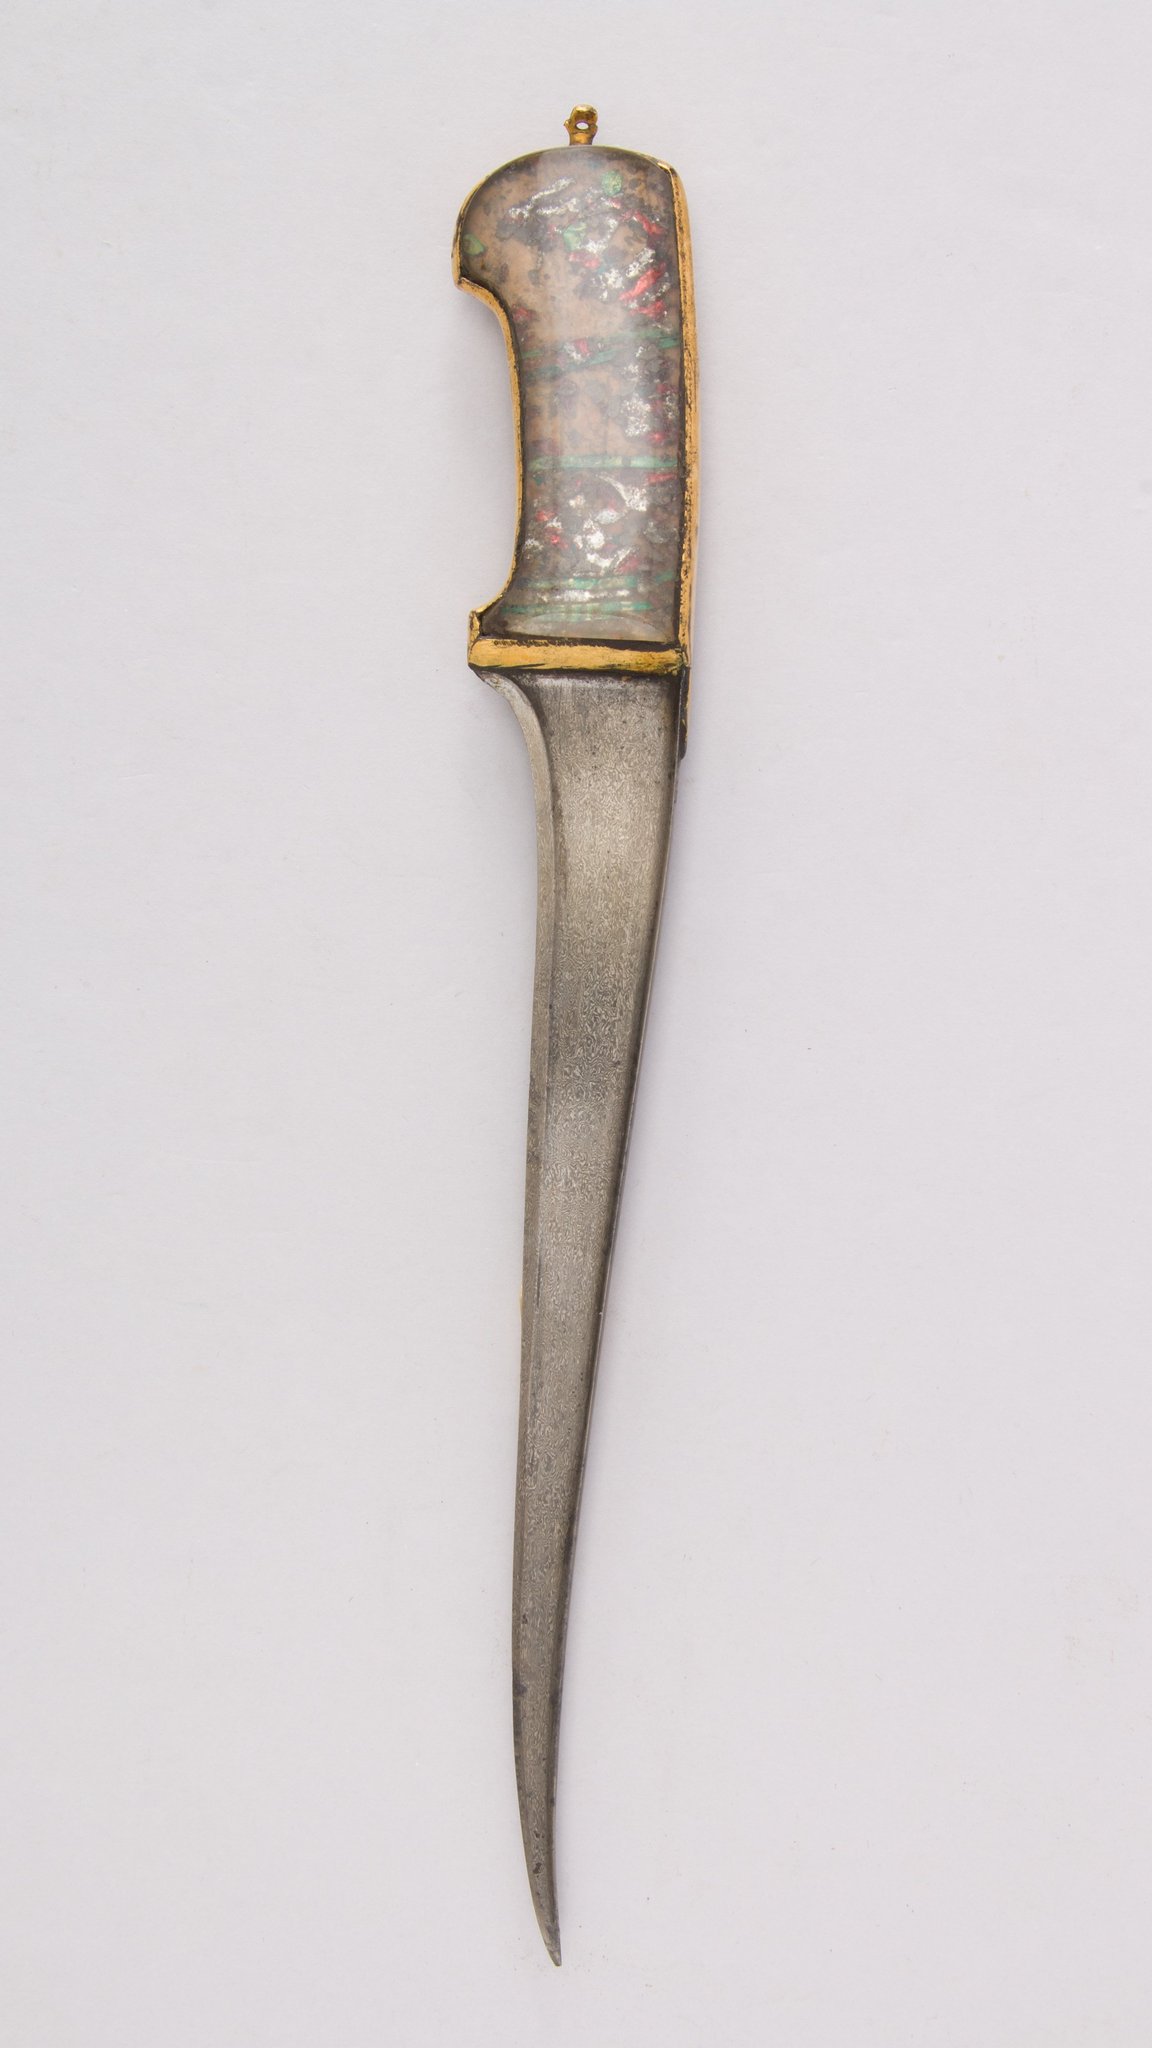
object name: dagger pesh kabz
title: Dagger (Pesh-kabz)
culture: indian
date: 1701-1900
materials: copper, crystal, foil, gold, paper, steel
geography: india